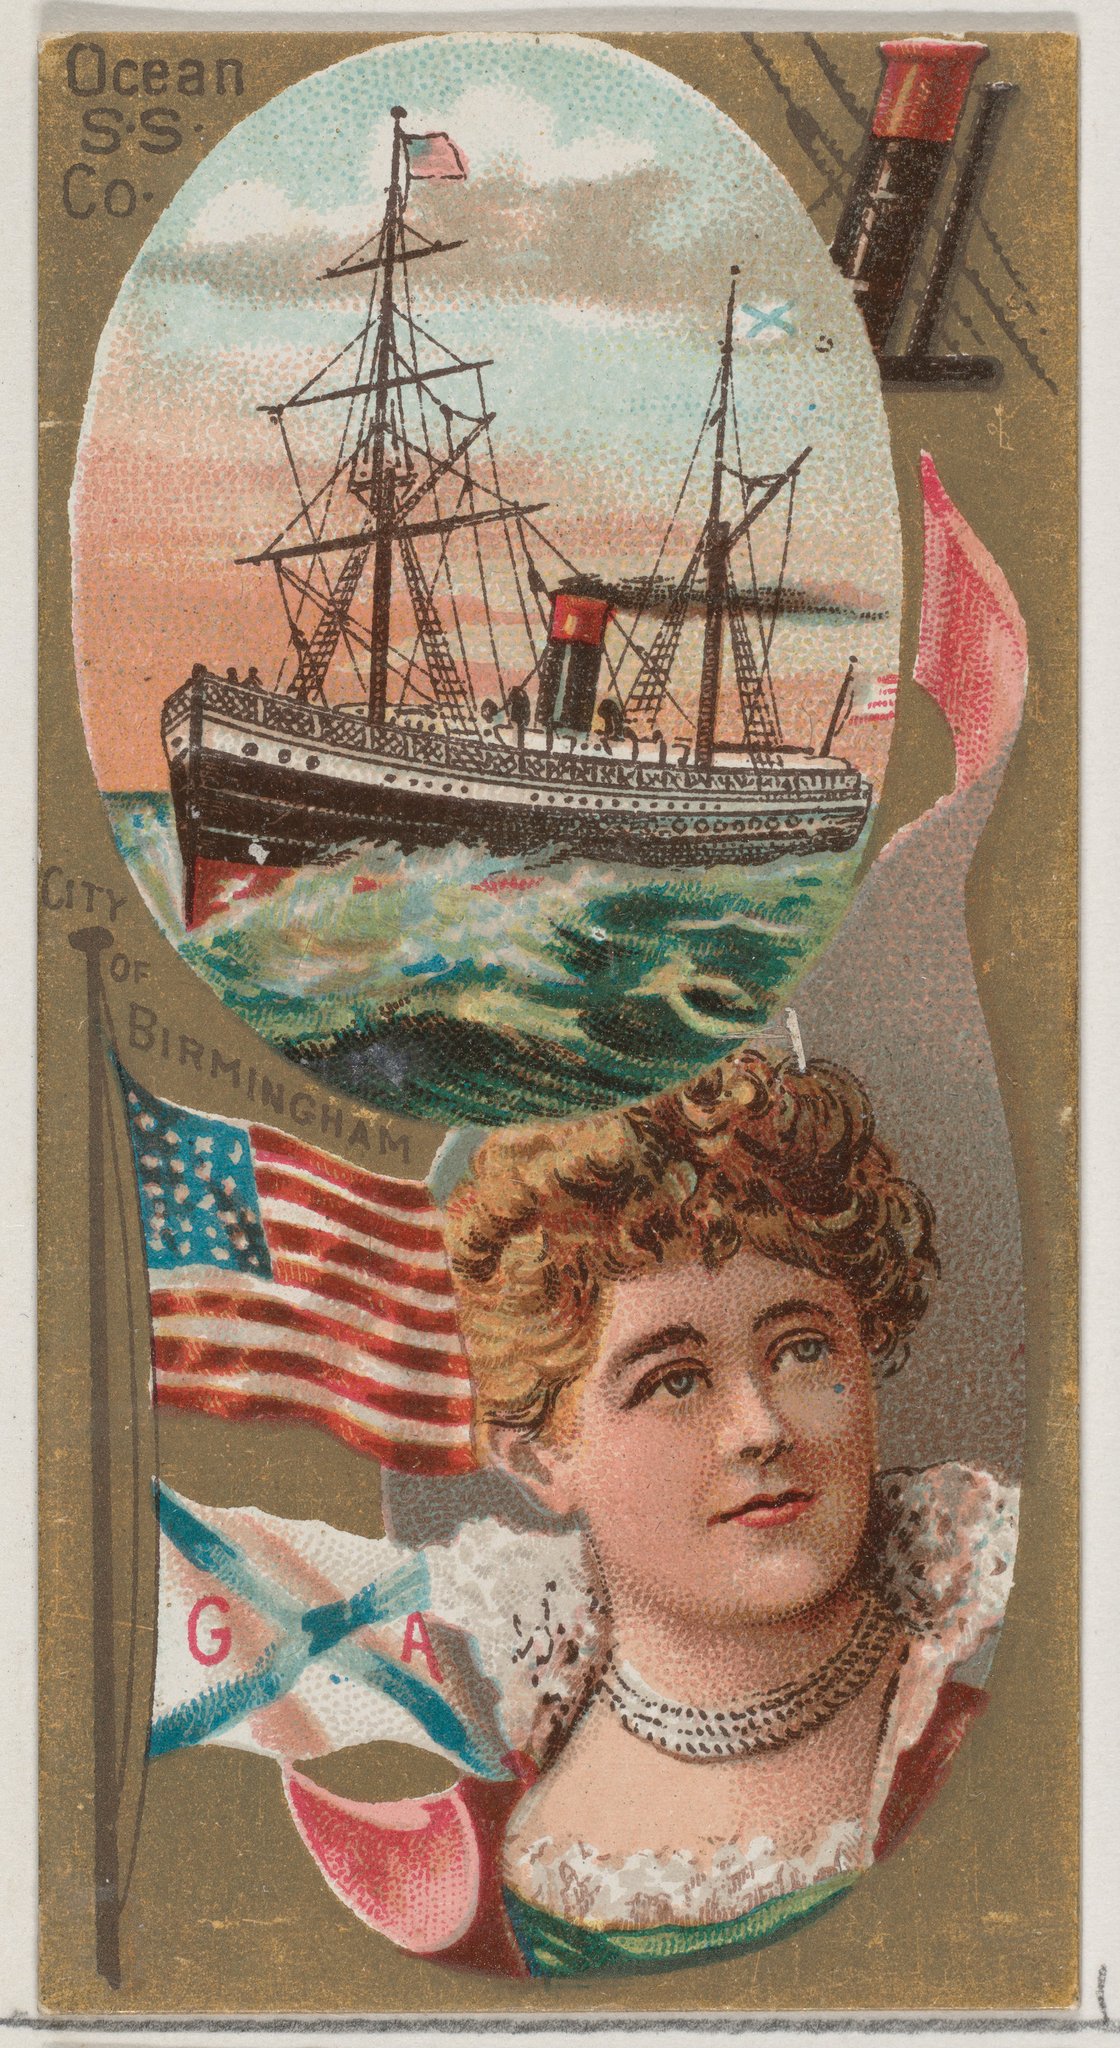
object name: print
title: Ocean Steamship Company, from the Ocean and River Steamers series (N83) for Duke brand cigarettes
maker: w. duke, sons & co.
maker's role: publisher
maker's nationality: american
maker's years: 1870-1920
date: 1887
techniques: color lithograph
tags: women,ships